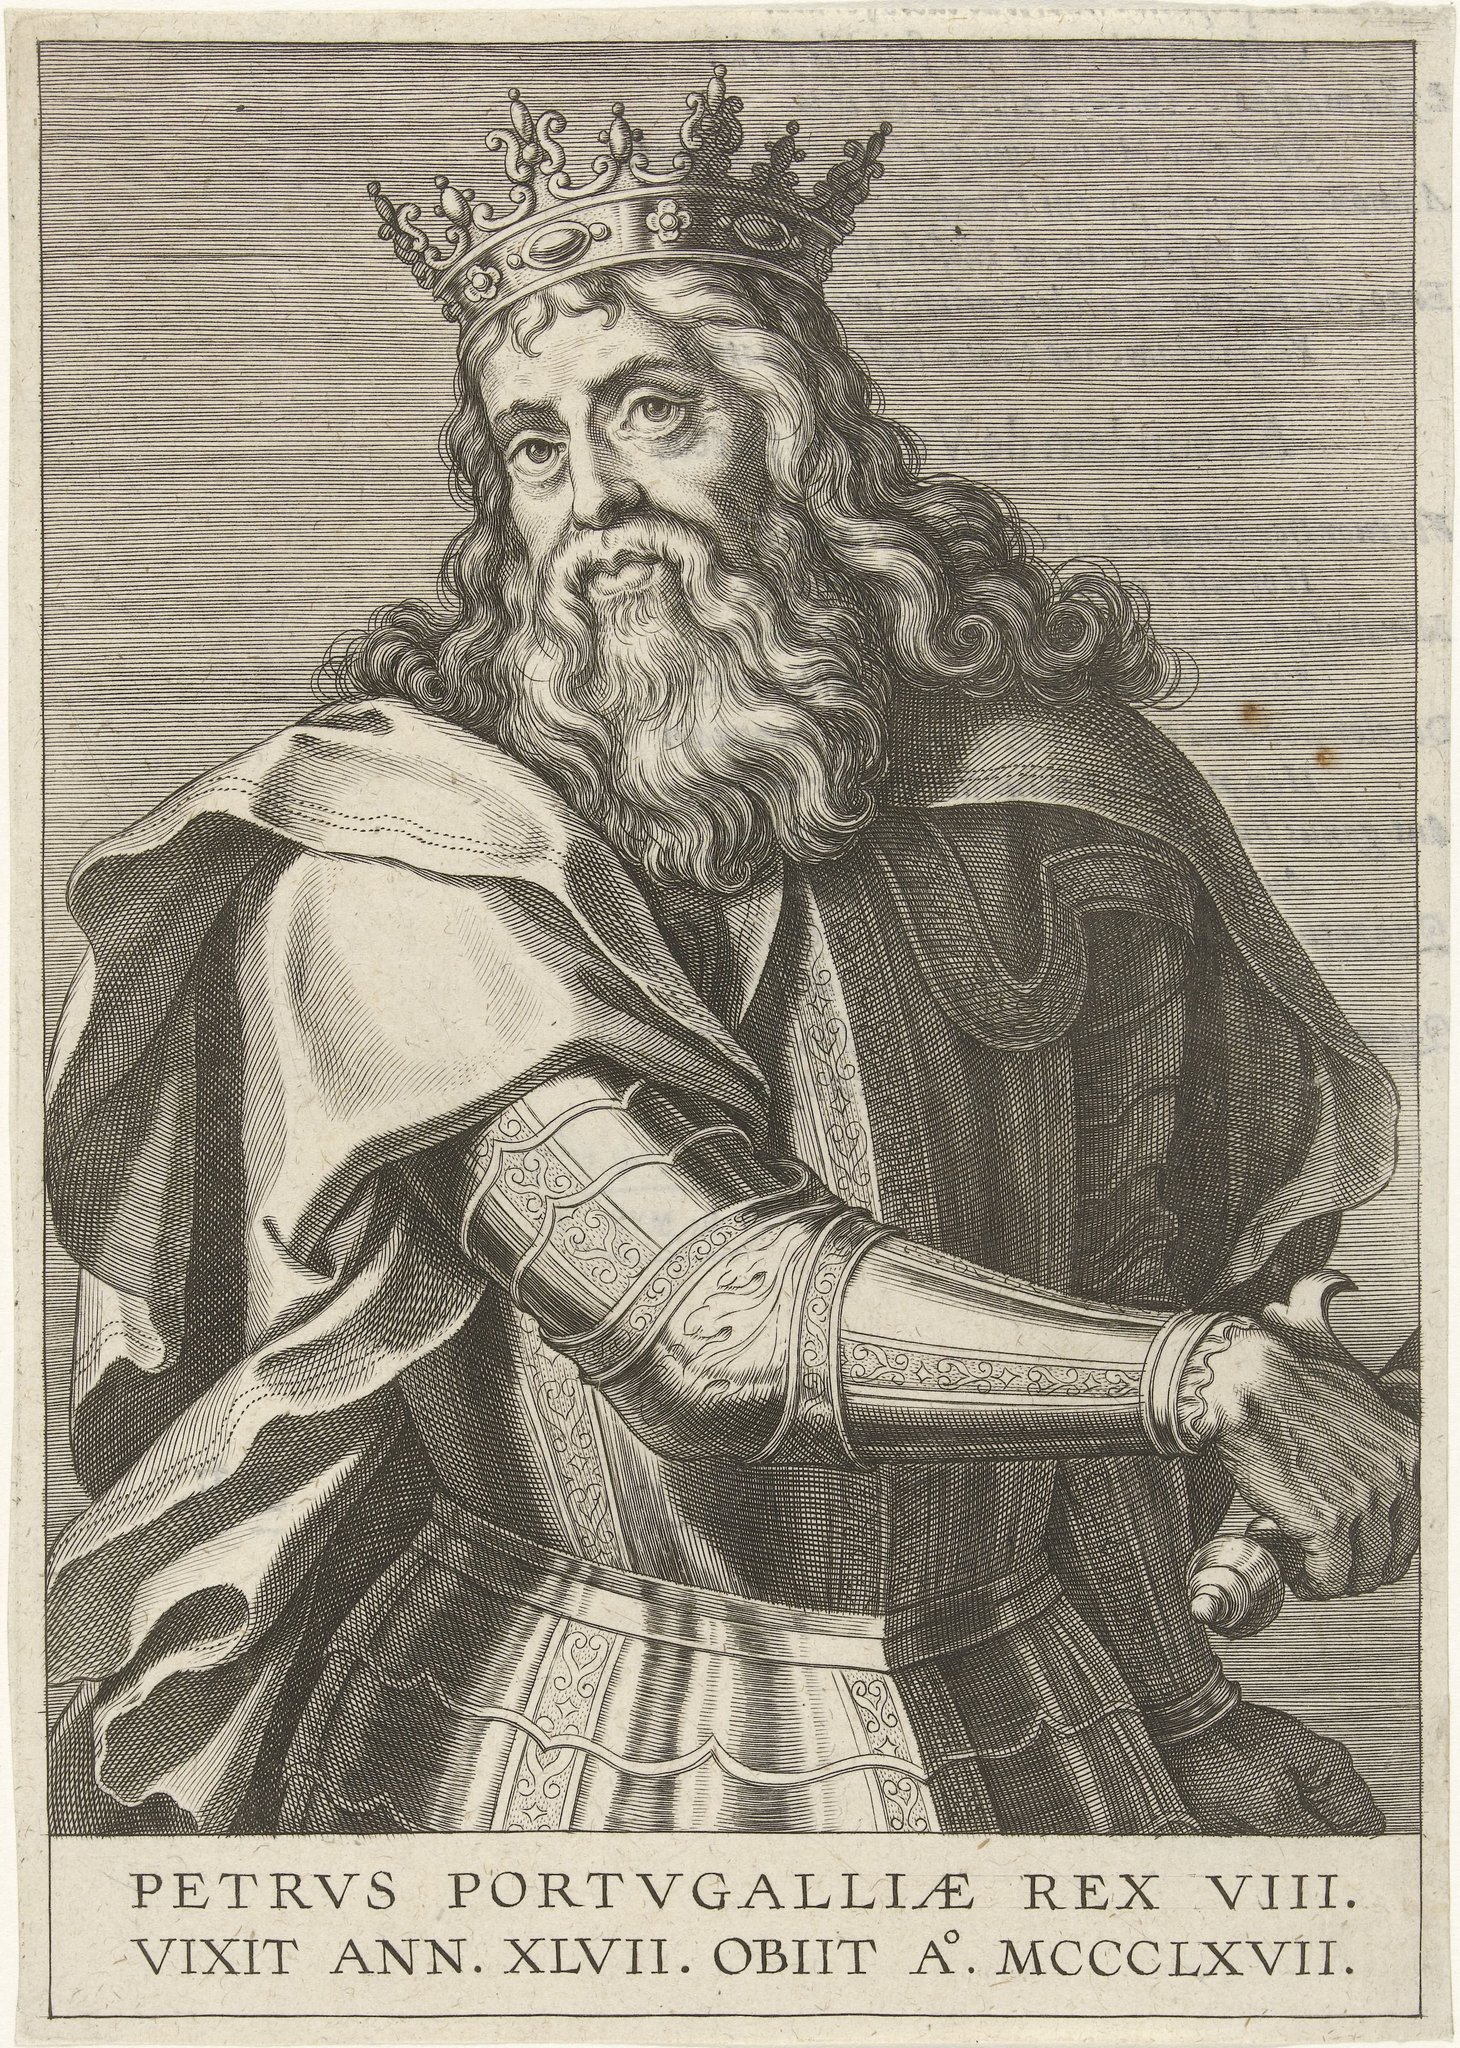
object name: print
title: Portret van koning Peter I van Portugal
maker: cornelis galle (i)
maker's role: print maker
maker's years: 1576-1650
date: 1621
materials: paper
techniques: engraving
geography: southern netherlands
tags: insignia and symbols of sovereignty (crown, diadem, sceptre, orb, seal, standard, cloak, pectoral)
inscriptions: collector's mark: Lugt 2228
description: Illustratie voor: Antonio Vasconcellos. Anacephalæoses id est, Svmma captia actorvm regvm Lvsitaniæ. Antwerpen: Petrus II en Joannes II Bellerus, 1621.